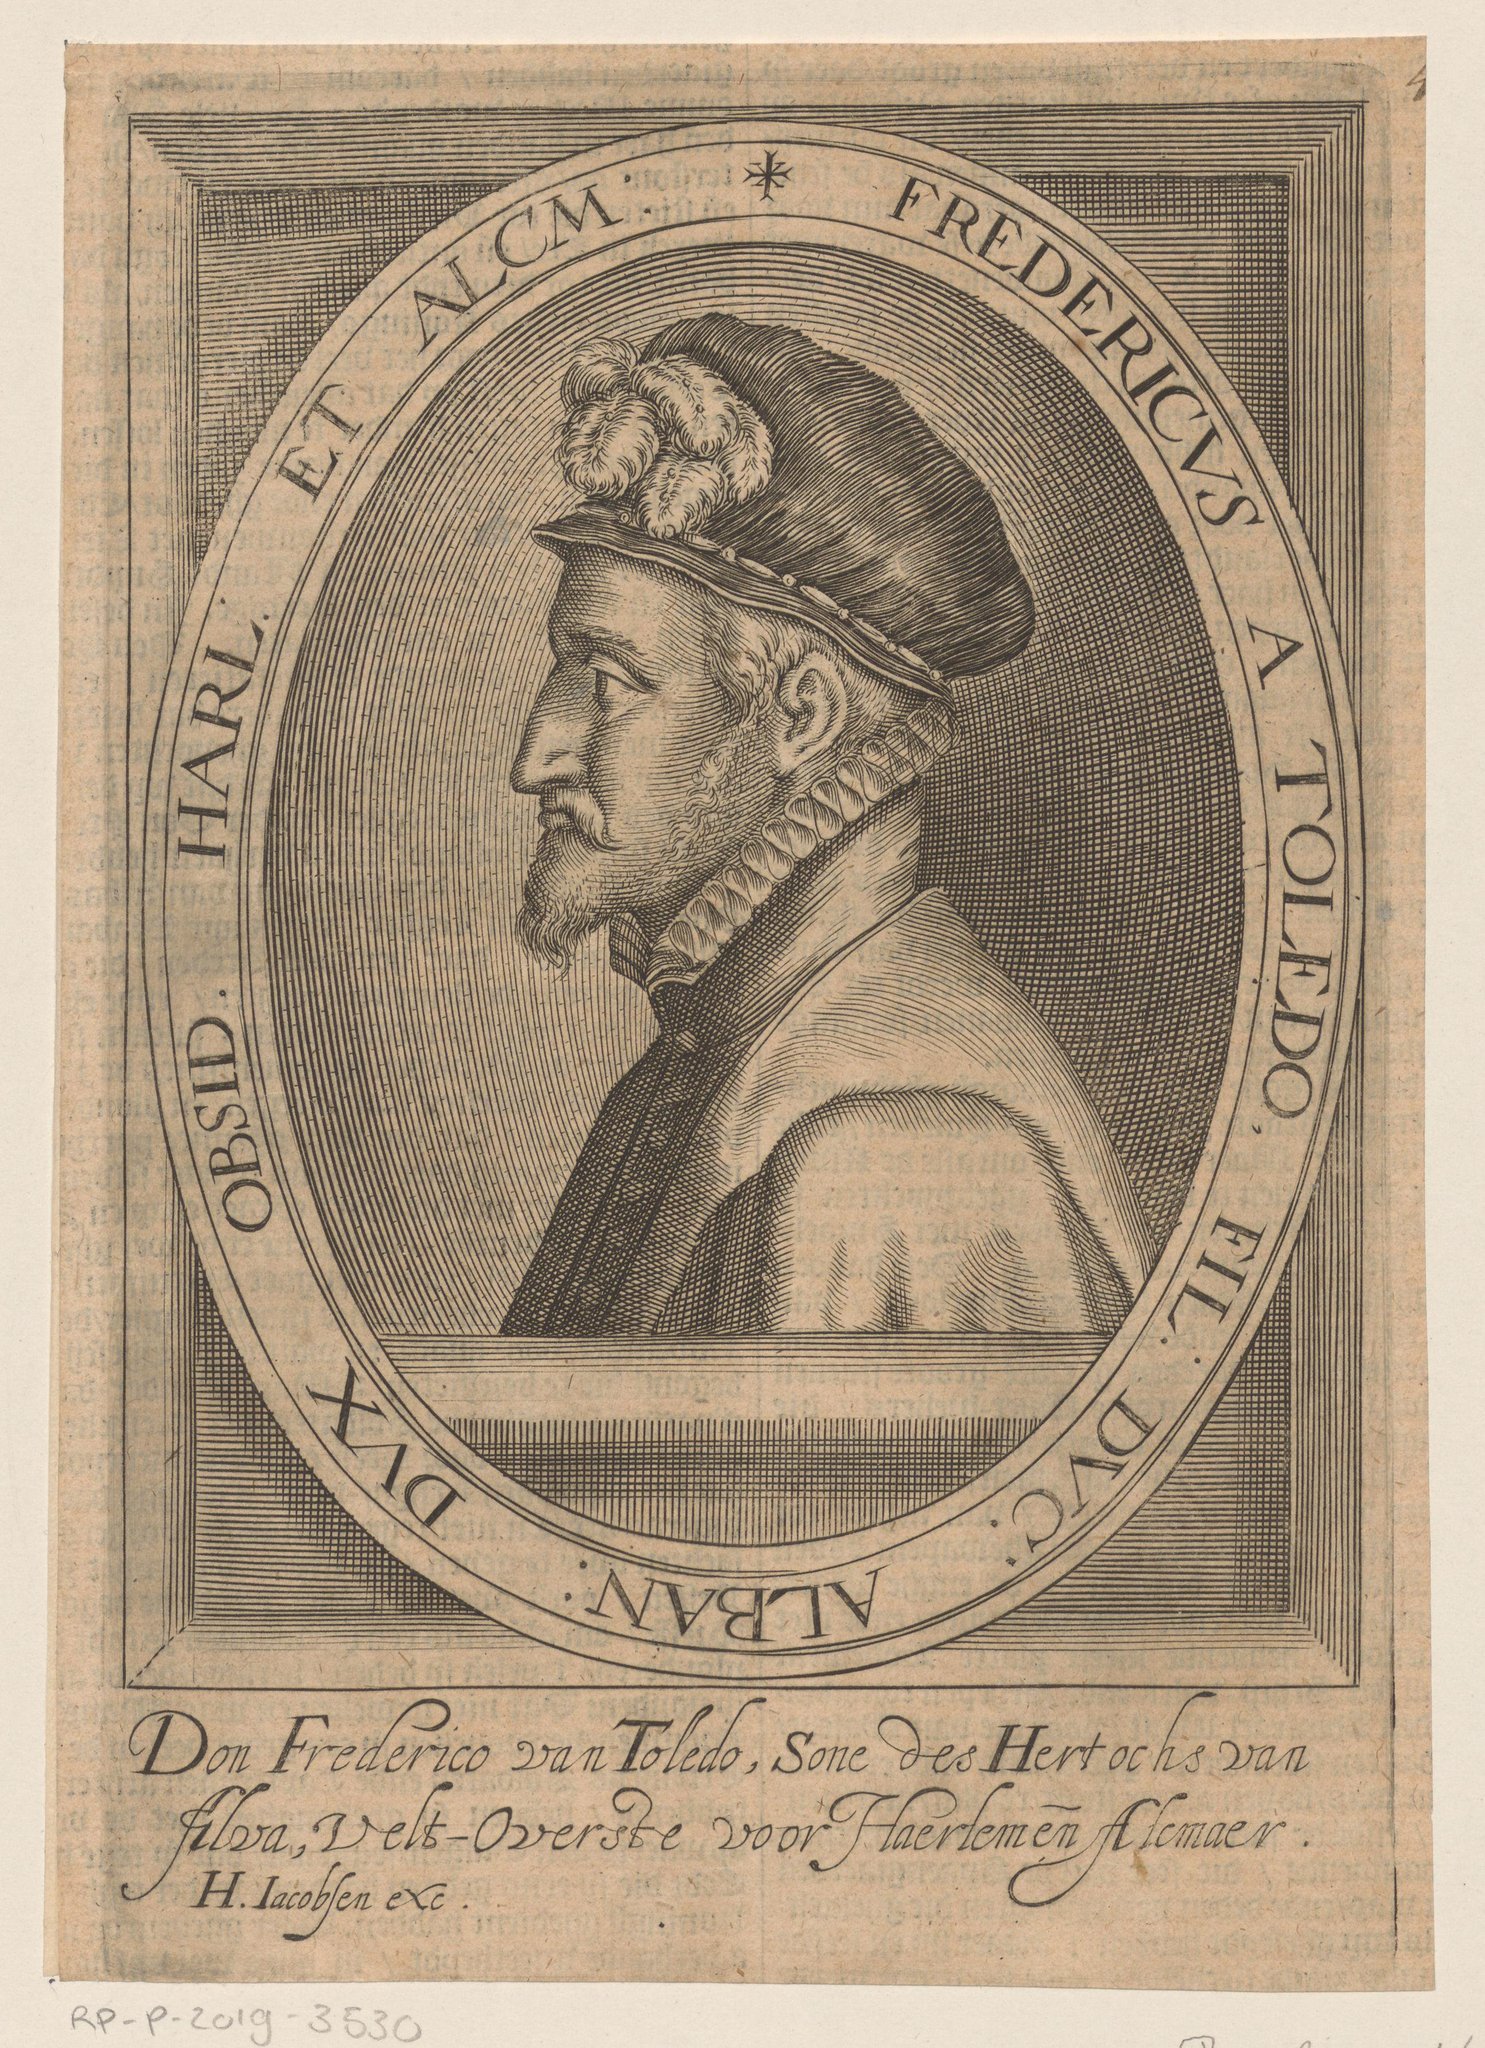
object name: book illustration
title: Portret van Fadrique Álvarez de Toledo, hertog van Alva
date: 1623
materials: paper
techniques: engraving, etching, letterpress printing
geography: the hague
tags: historical persons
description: Prent uit: Meteren, Emanuel van. Historie der Nederlandscher ender haerder naburen oorlogen ende geschiedenissen (...). Den Haag: Hillebrant Jacobsz van Wouw, 1623, f. 85.